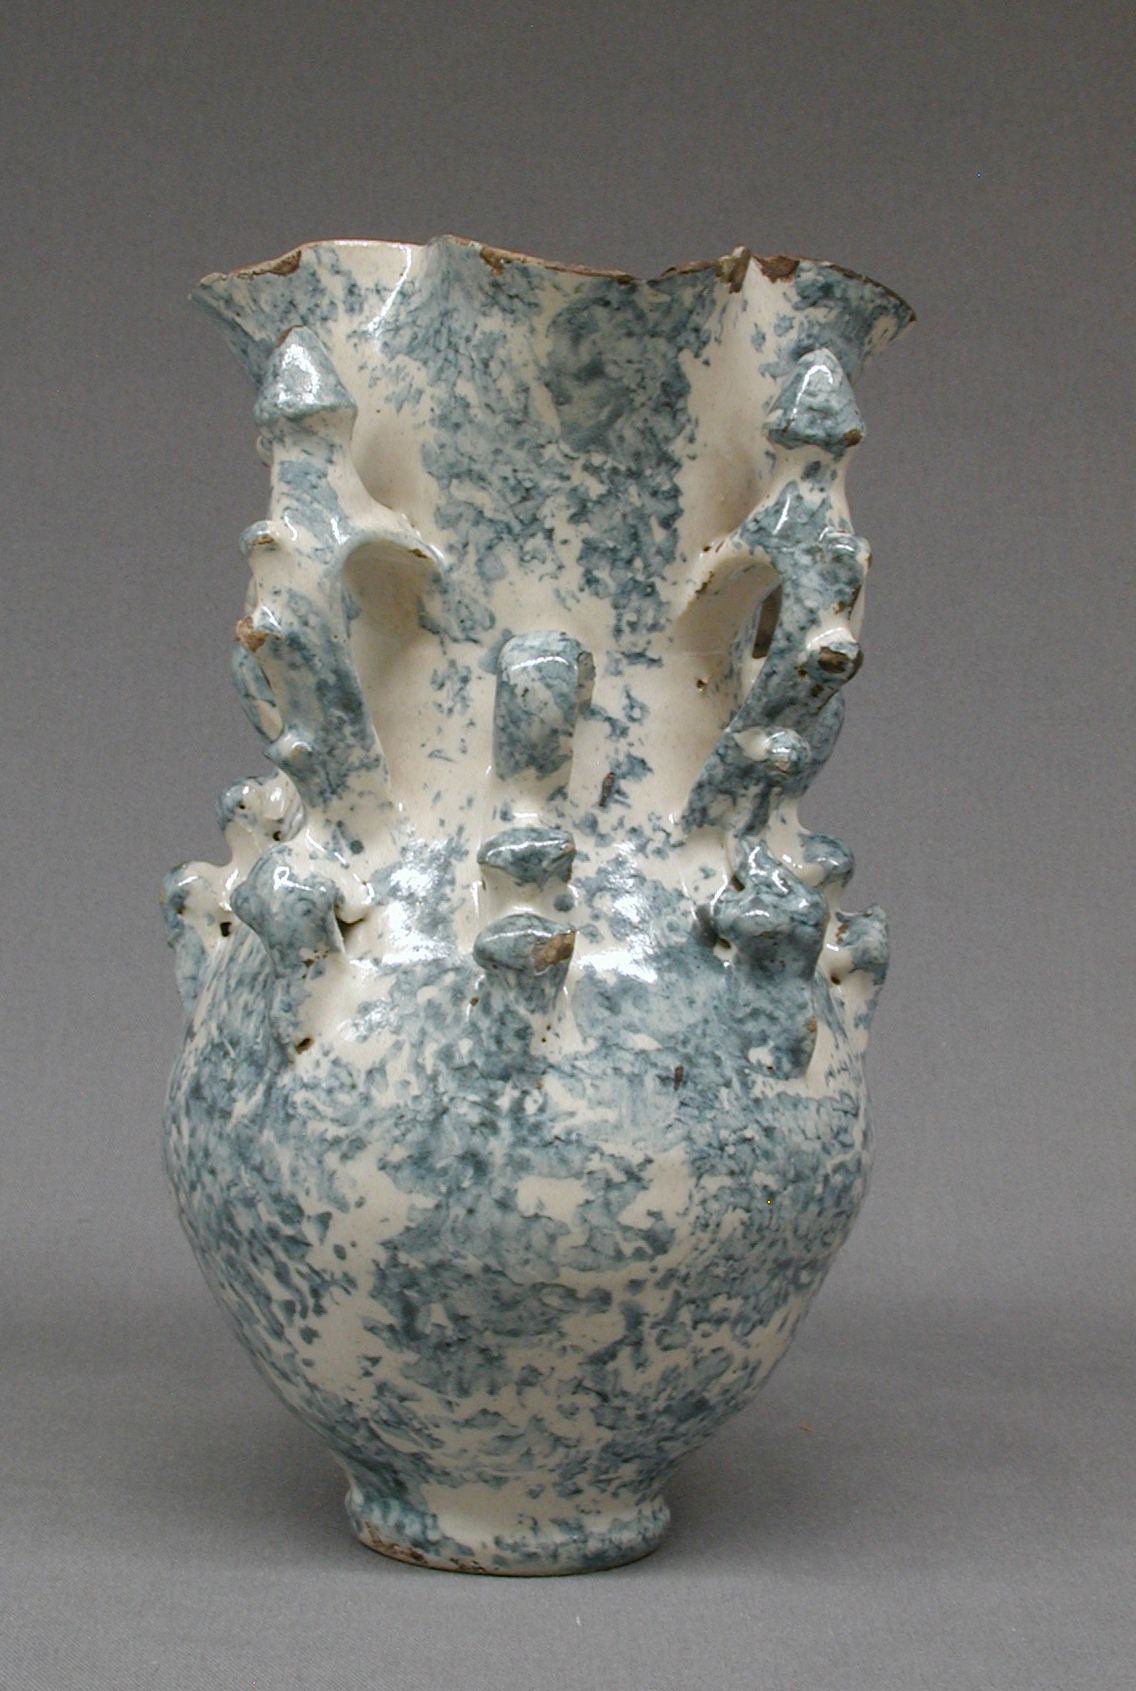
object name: vase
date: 1701-1800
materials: earthenware